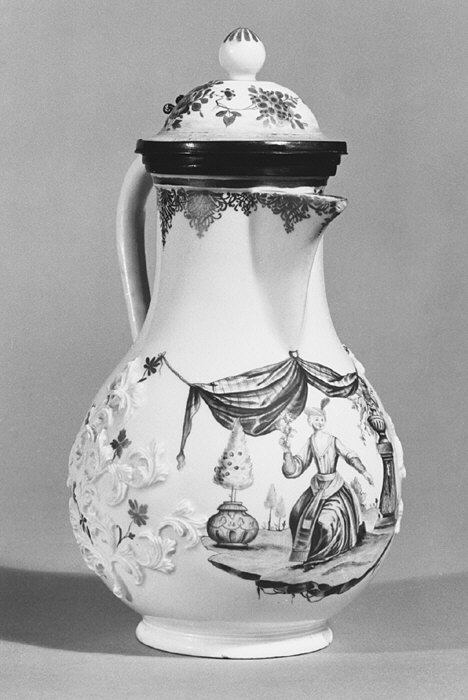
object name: coffeepot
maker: meissen manufactory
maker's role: manufactory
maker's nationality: german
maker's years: 1710-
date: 1715-1740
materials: hard paste porcelain, silver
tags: women,flowers